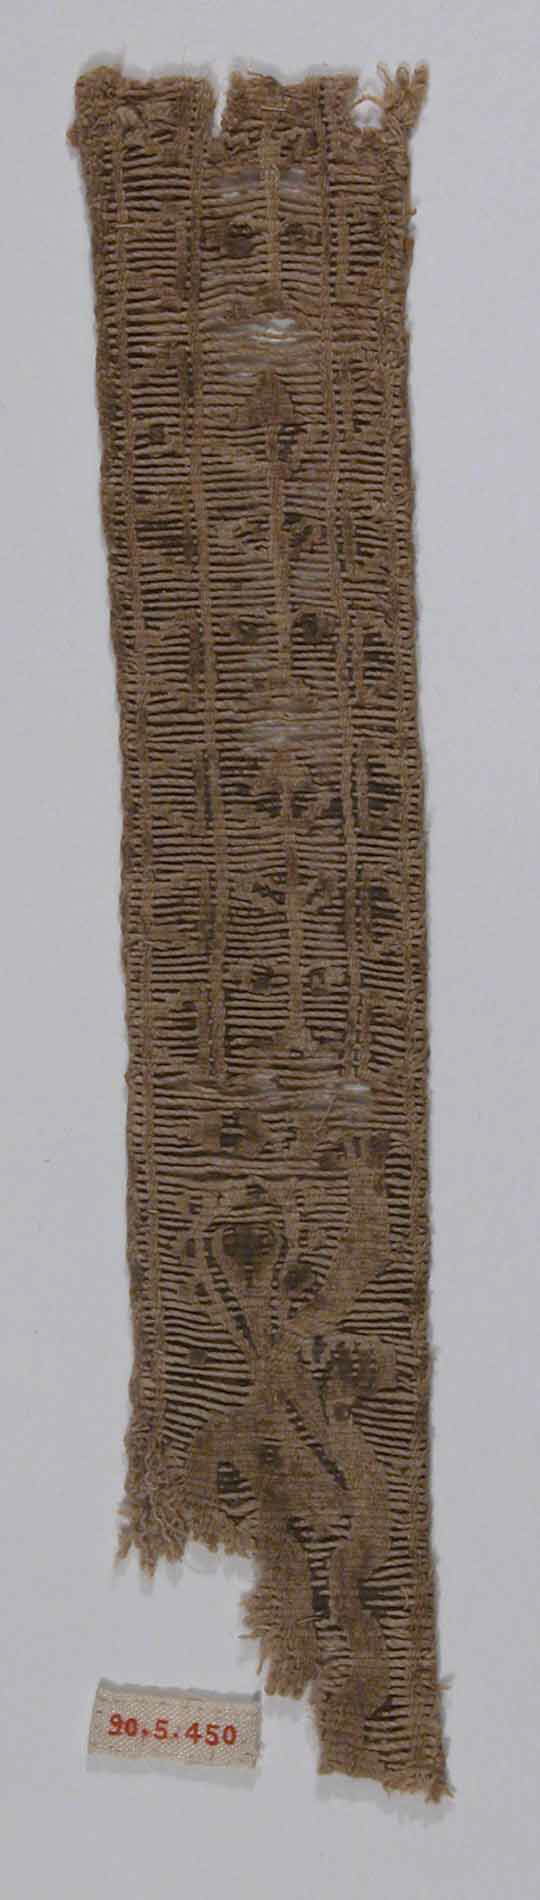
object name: textile fragment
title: Fragment of Shoulder Band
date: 401-500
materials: linen, wool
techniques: weave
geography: egypt